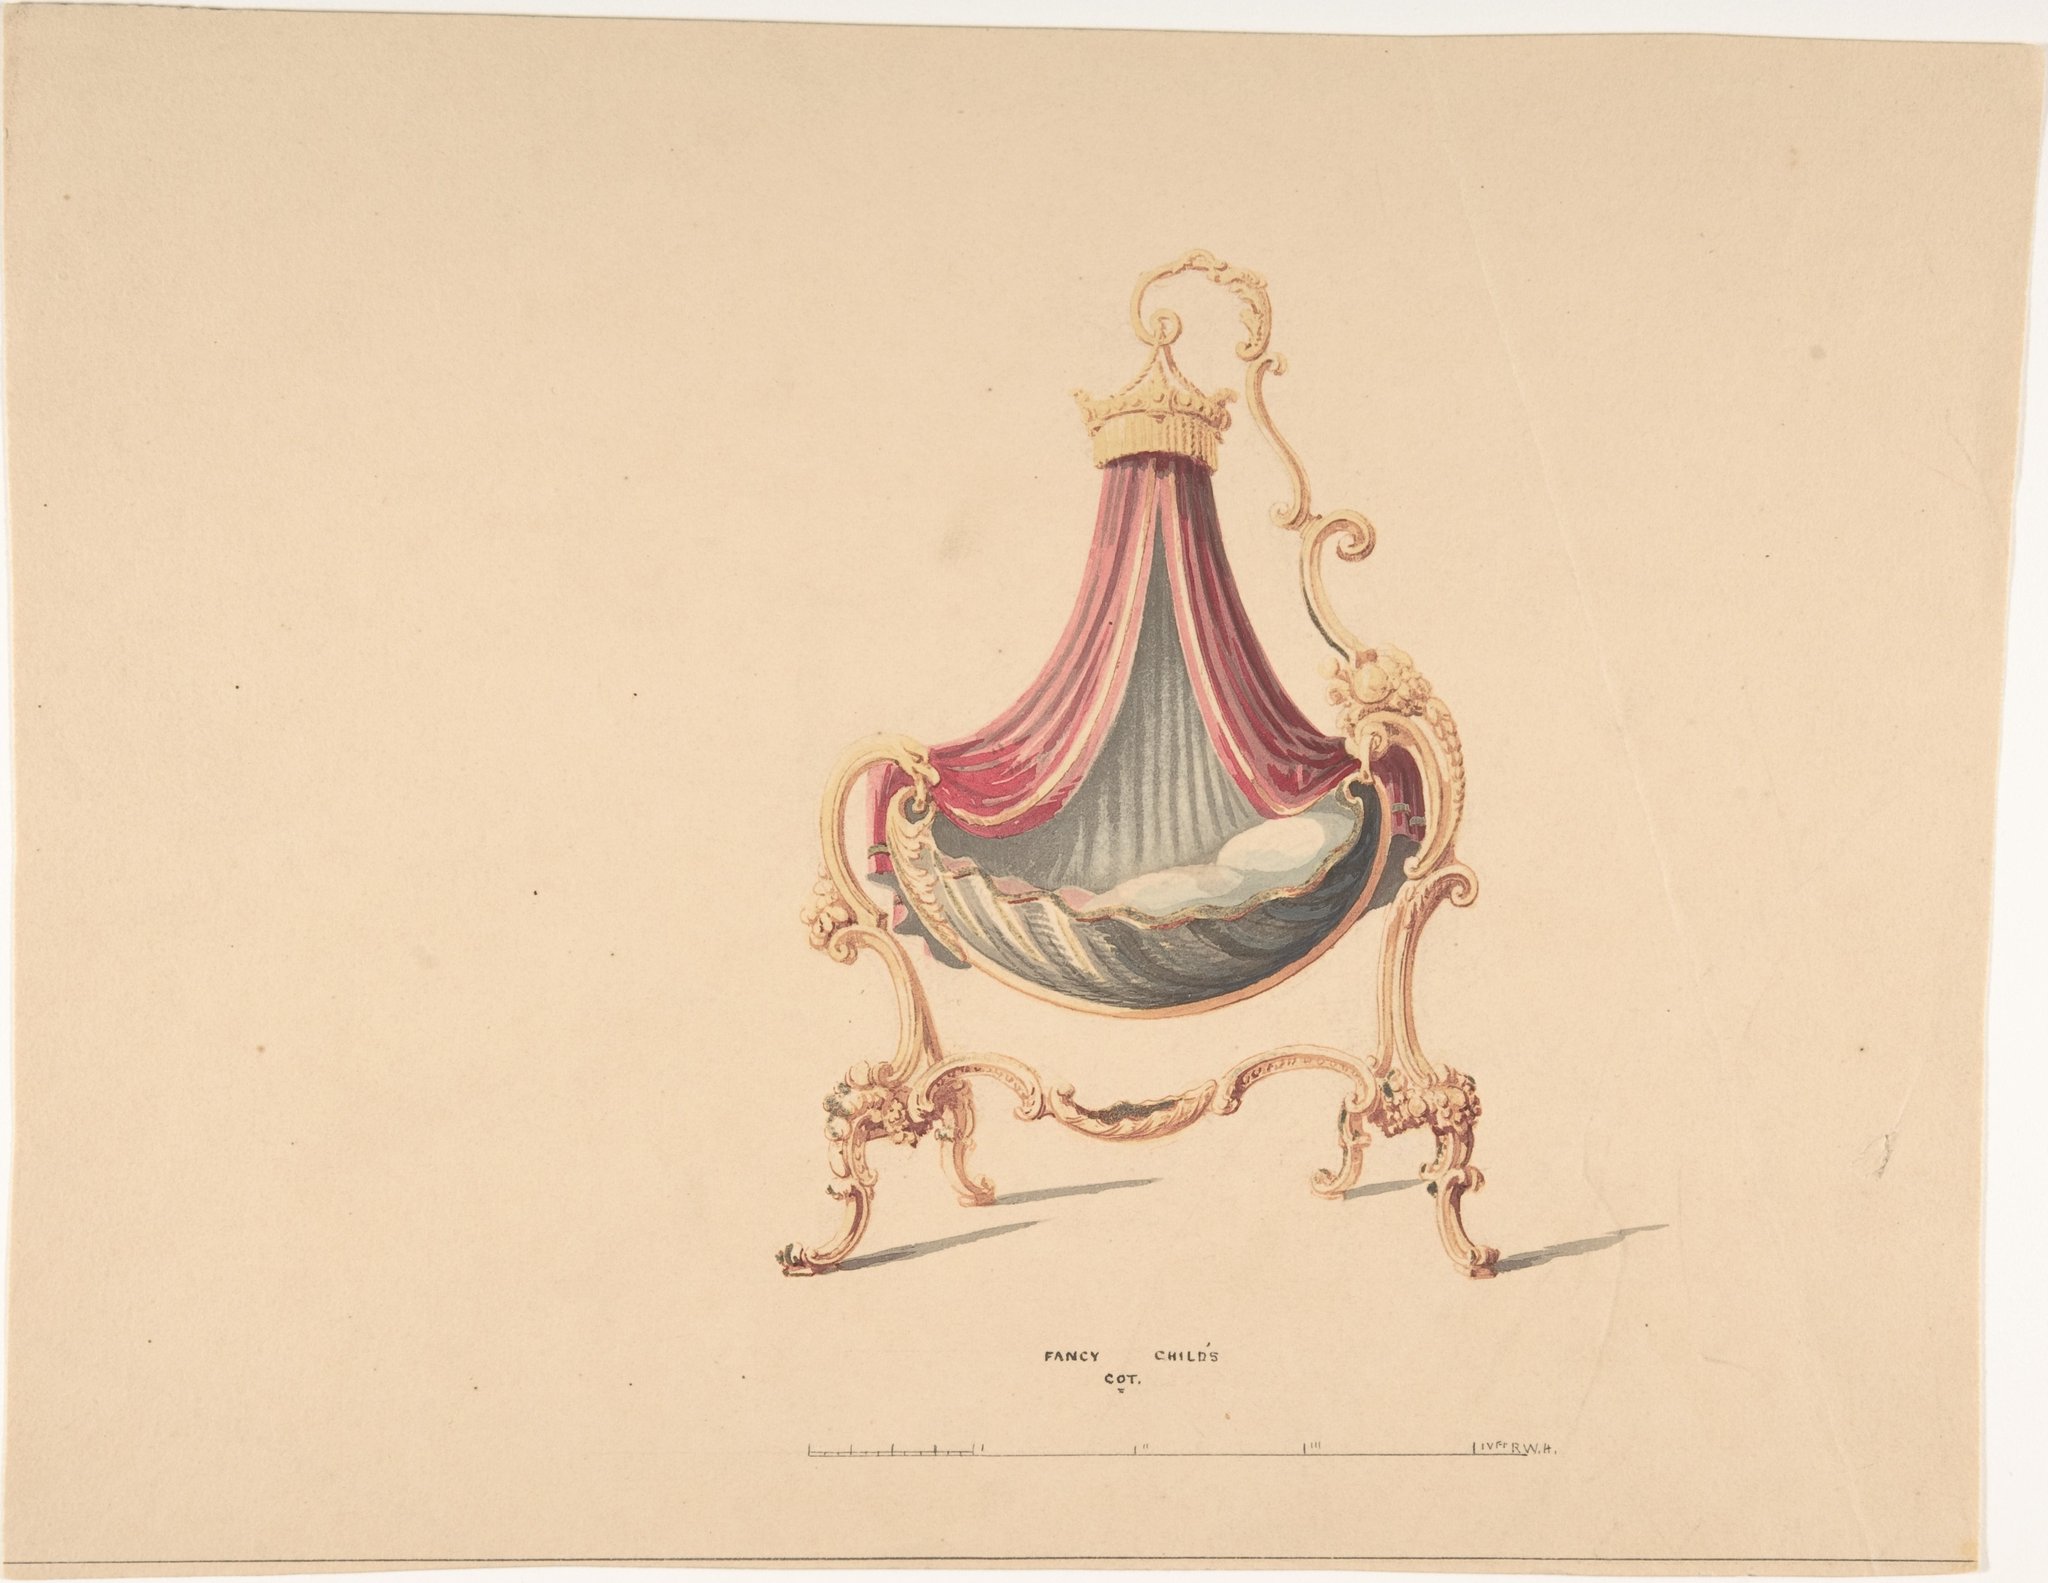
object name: drawing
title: Design for Fancy Child's Cot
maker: robert william hume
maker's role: artist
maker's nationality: british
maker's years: 1816-1904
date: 1830-1900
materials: graphite, ink, watercolor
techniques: pen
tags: cradles